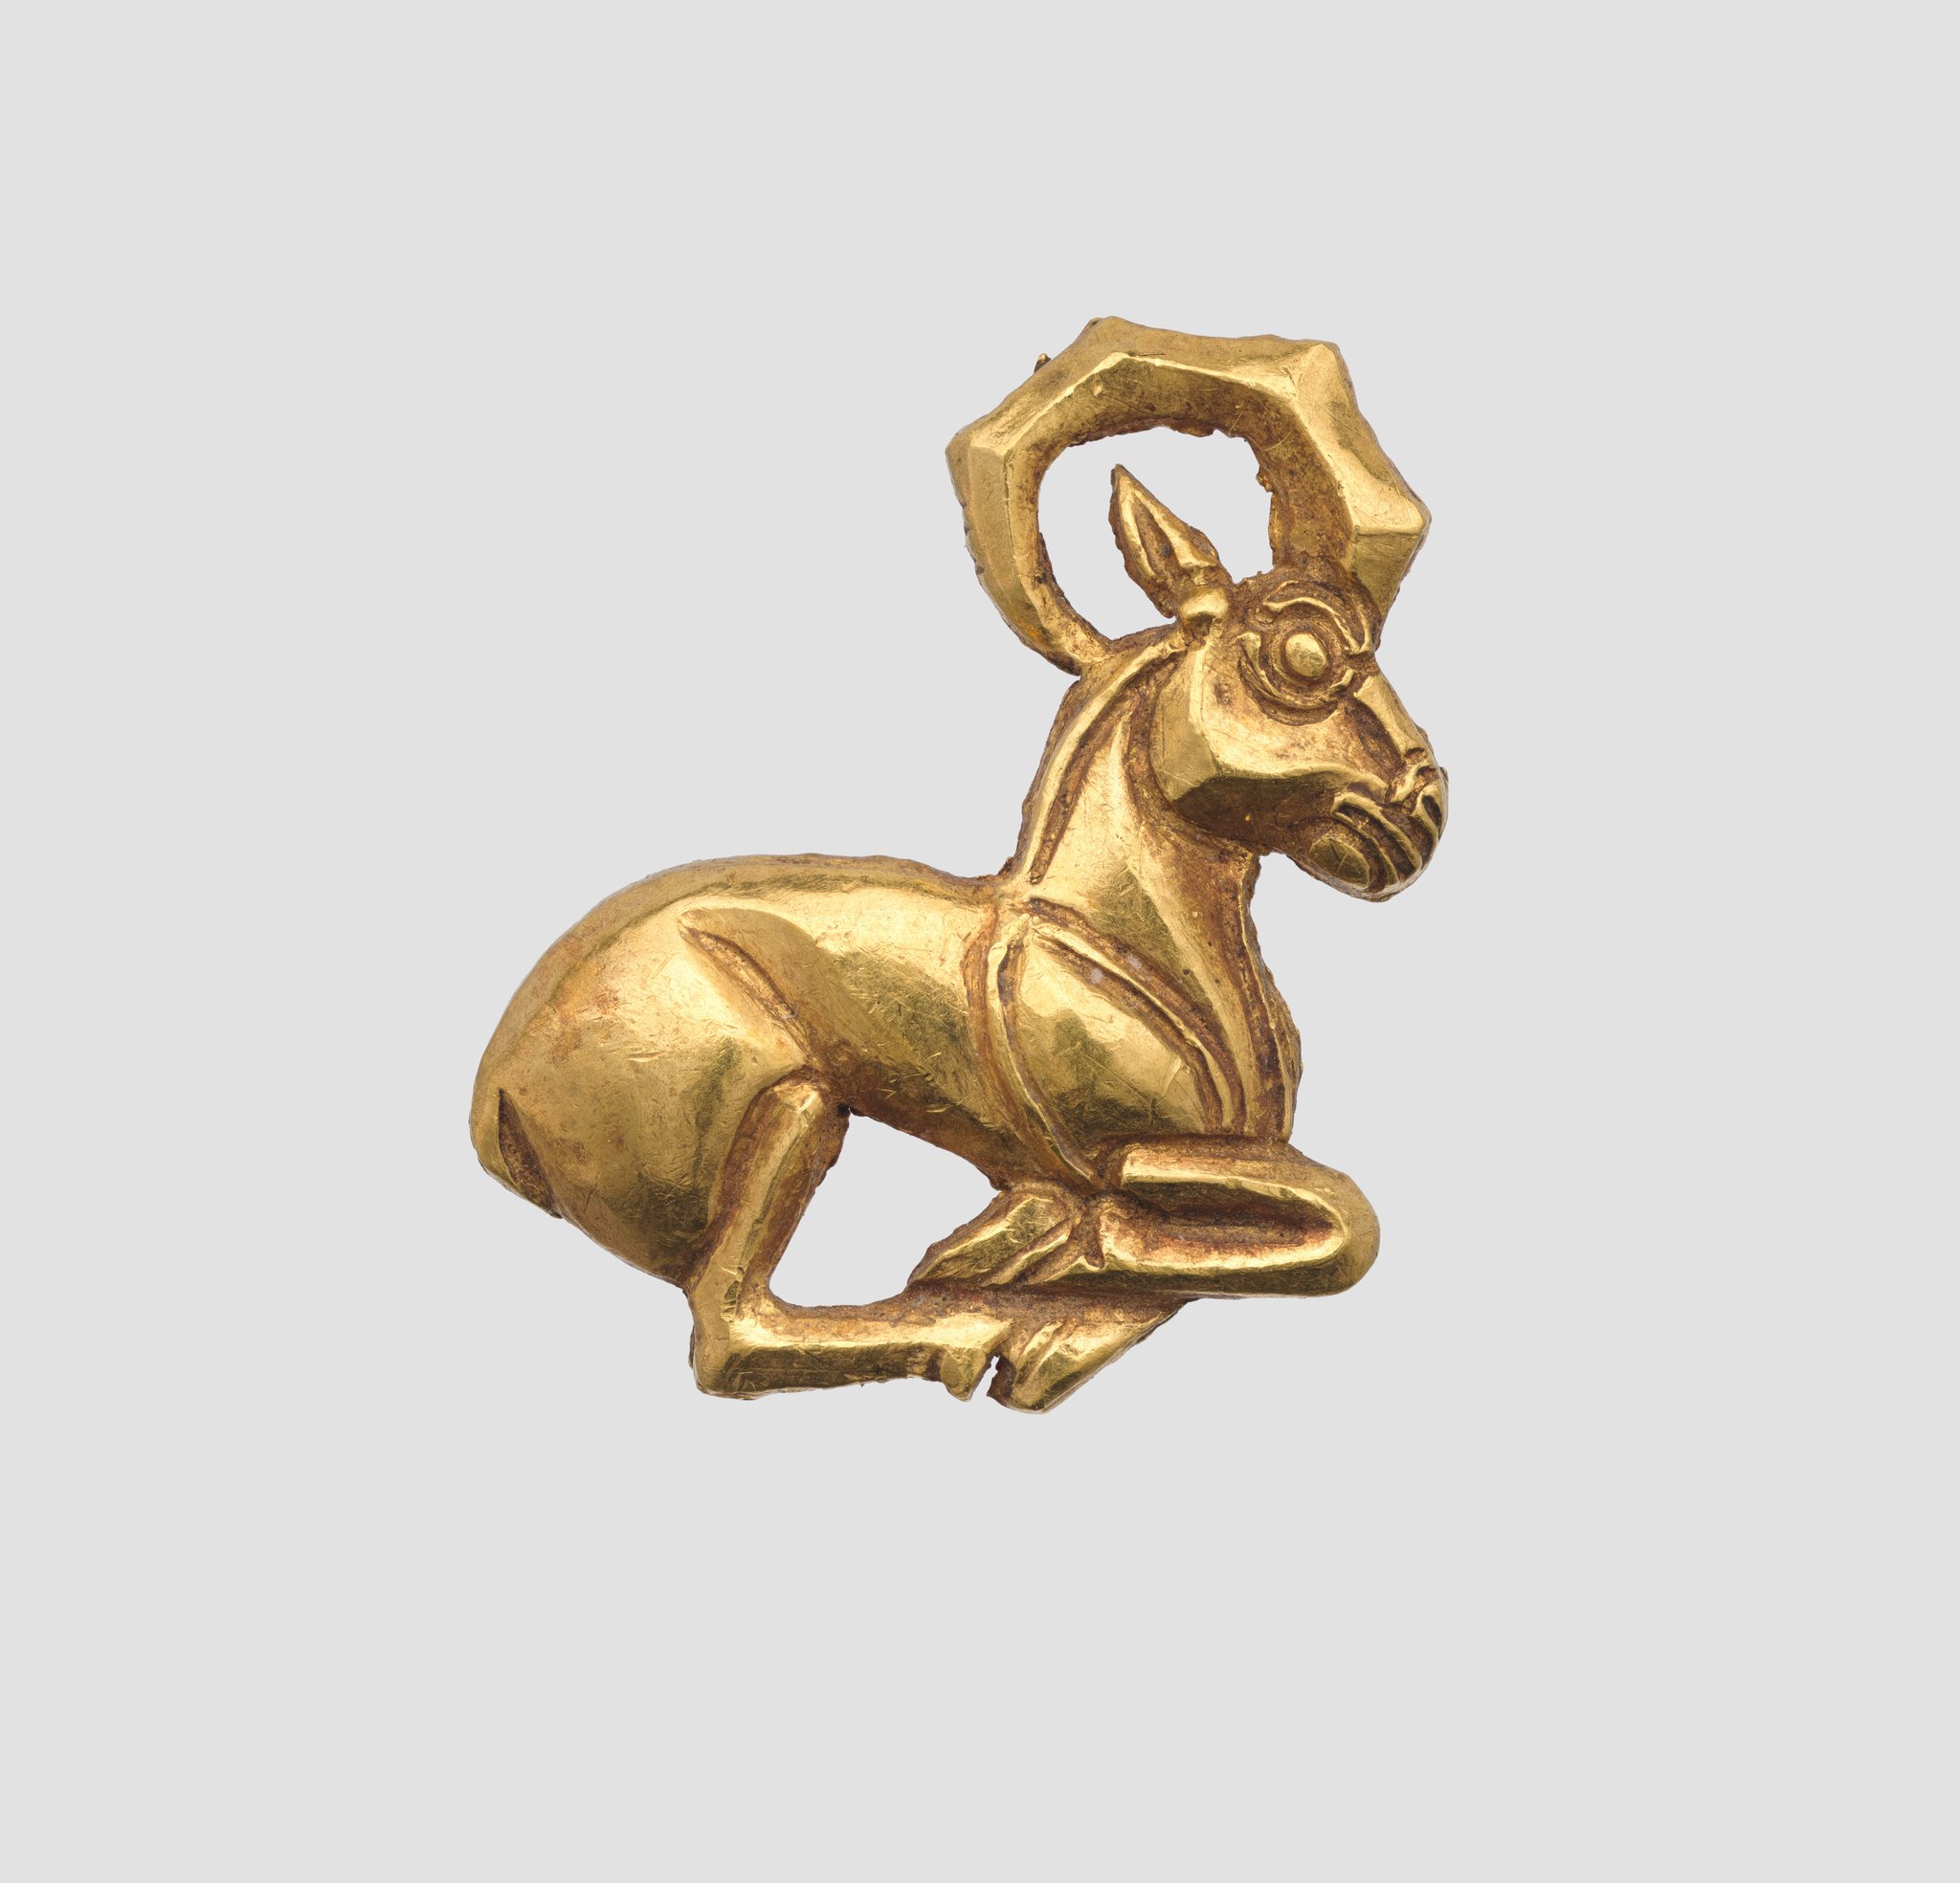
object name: sculpture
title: Figure of an ibex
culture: iranian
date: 800-601 BCE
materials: gold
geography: iran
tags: ibex